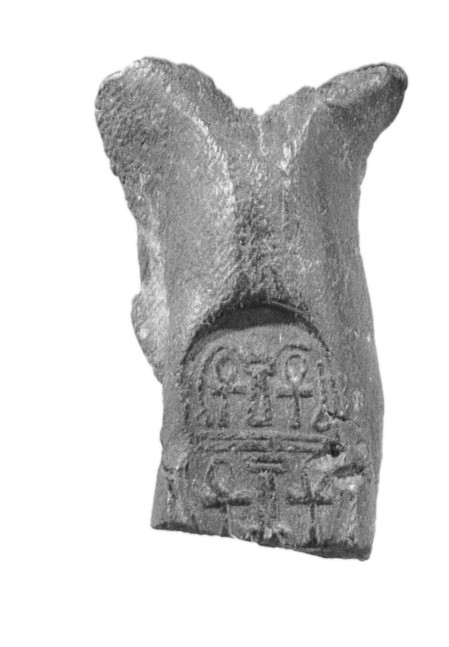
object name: sealing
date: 2030-1640 BCE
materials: clay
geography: egypt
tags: ankh